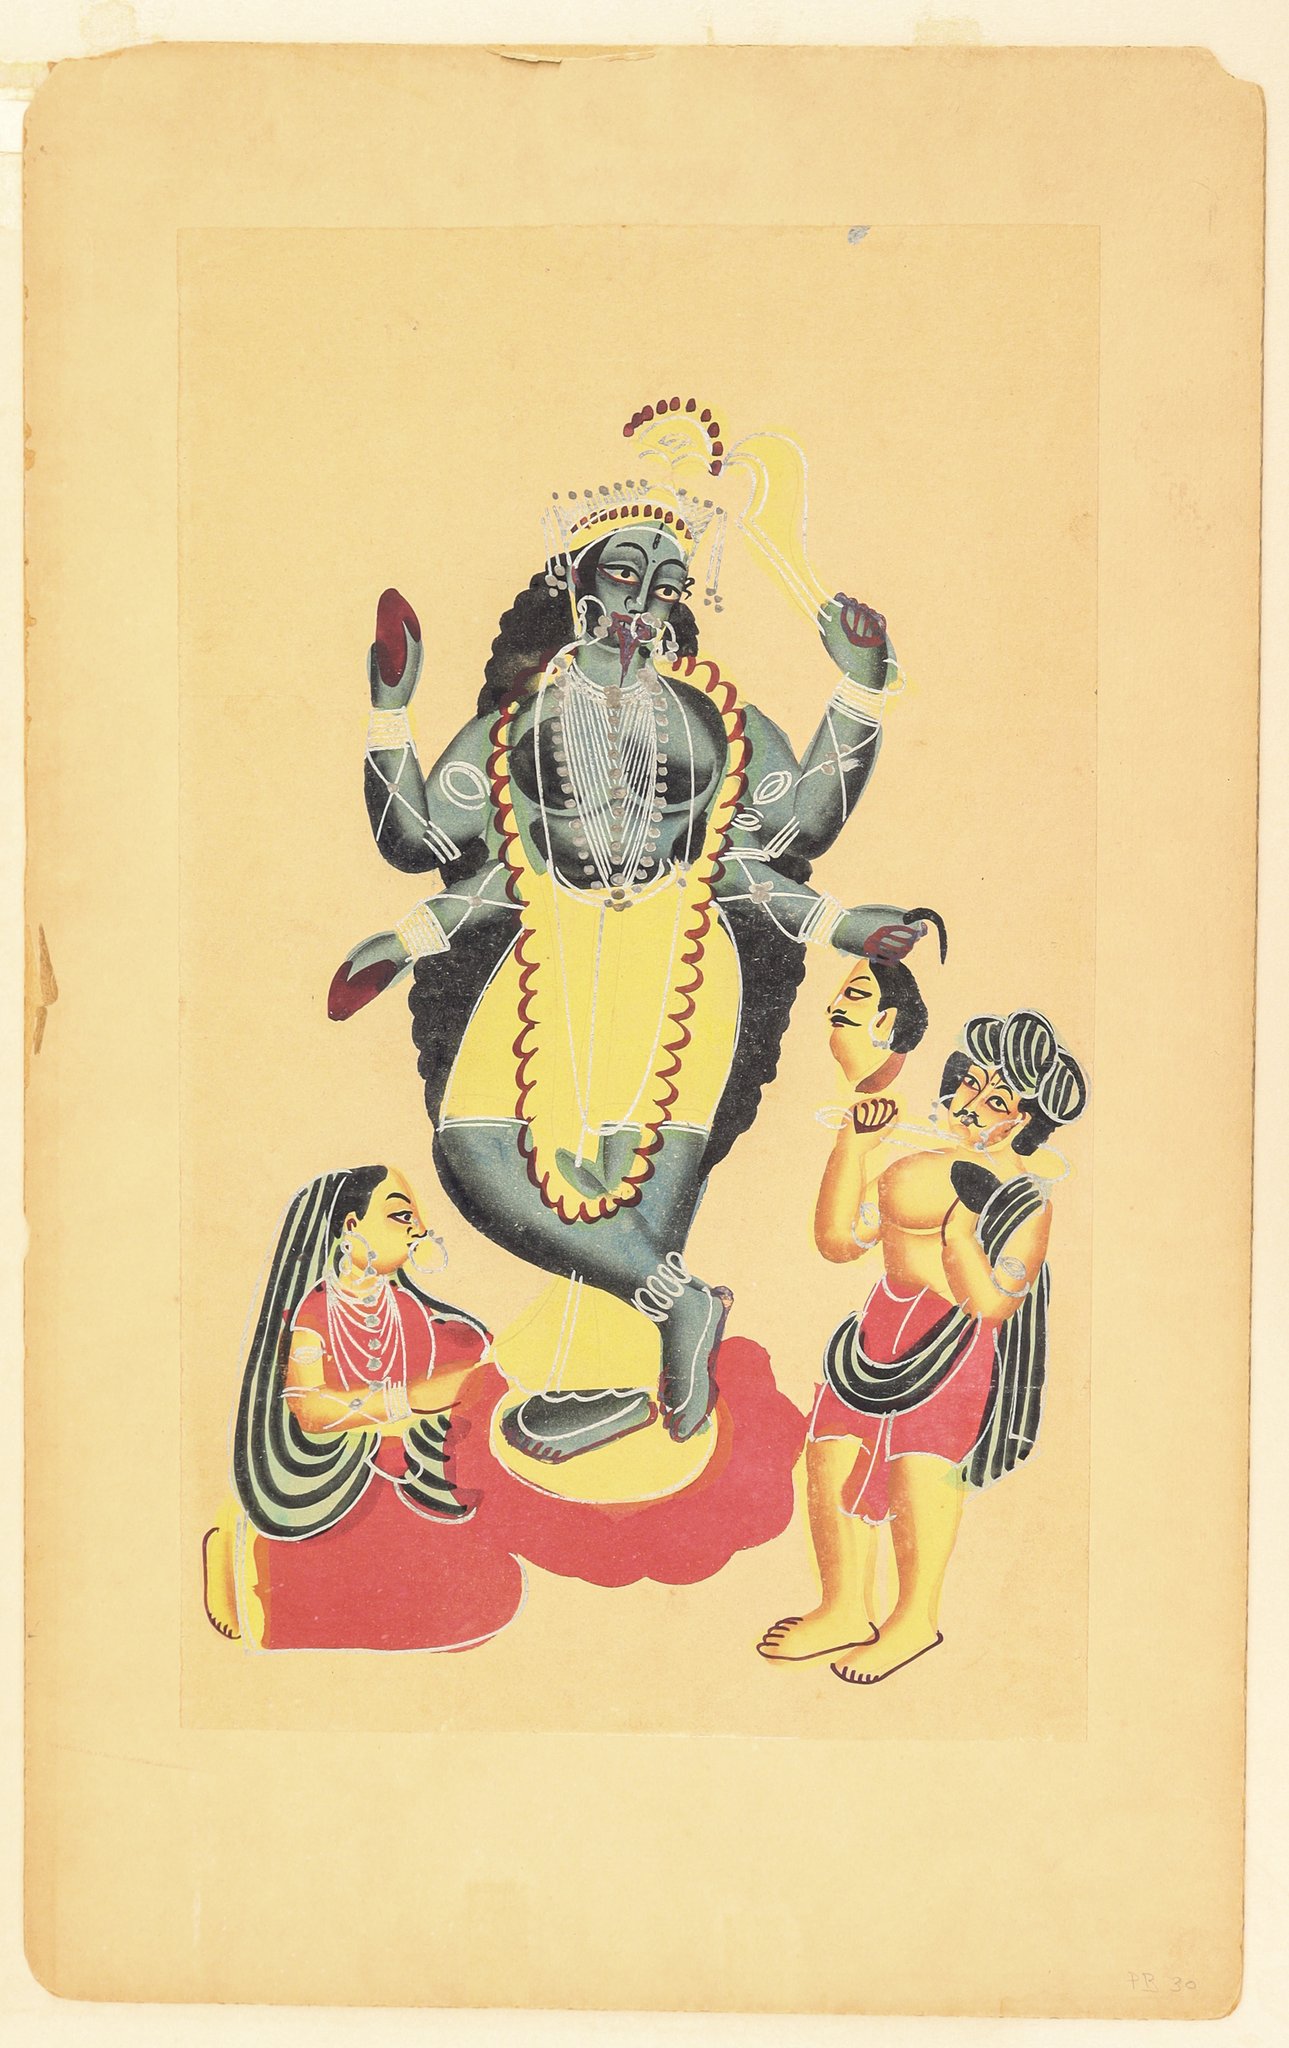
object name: painting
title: Radha Worships Krishna as Kali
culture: indian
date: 1867-1900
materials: paper, watercolor